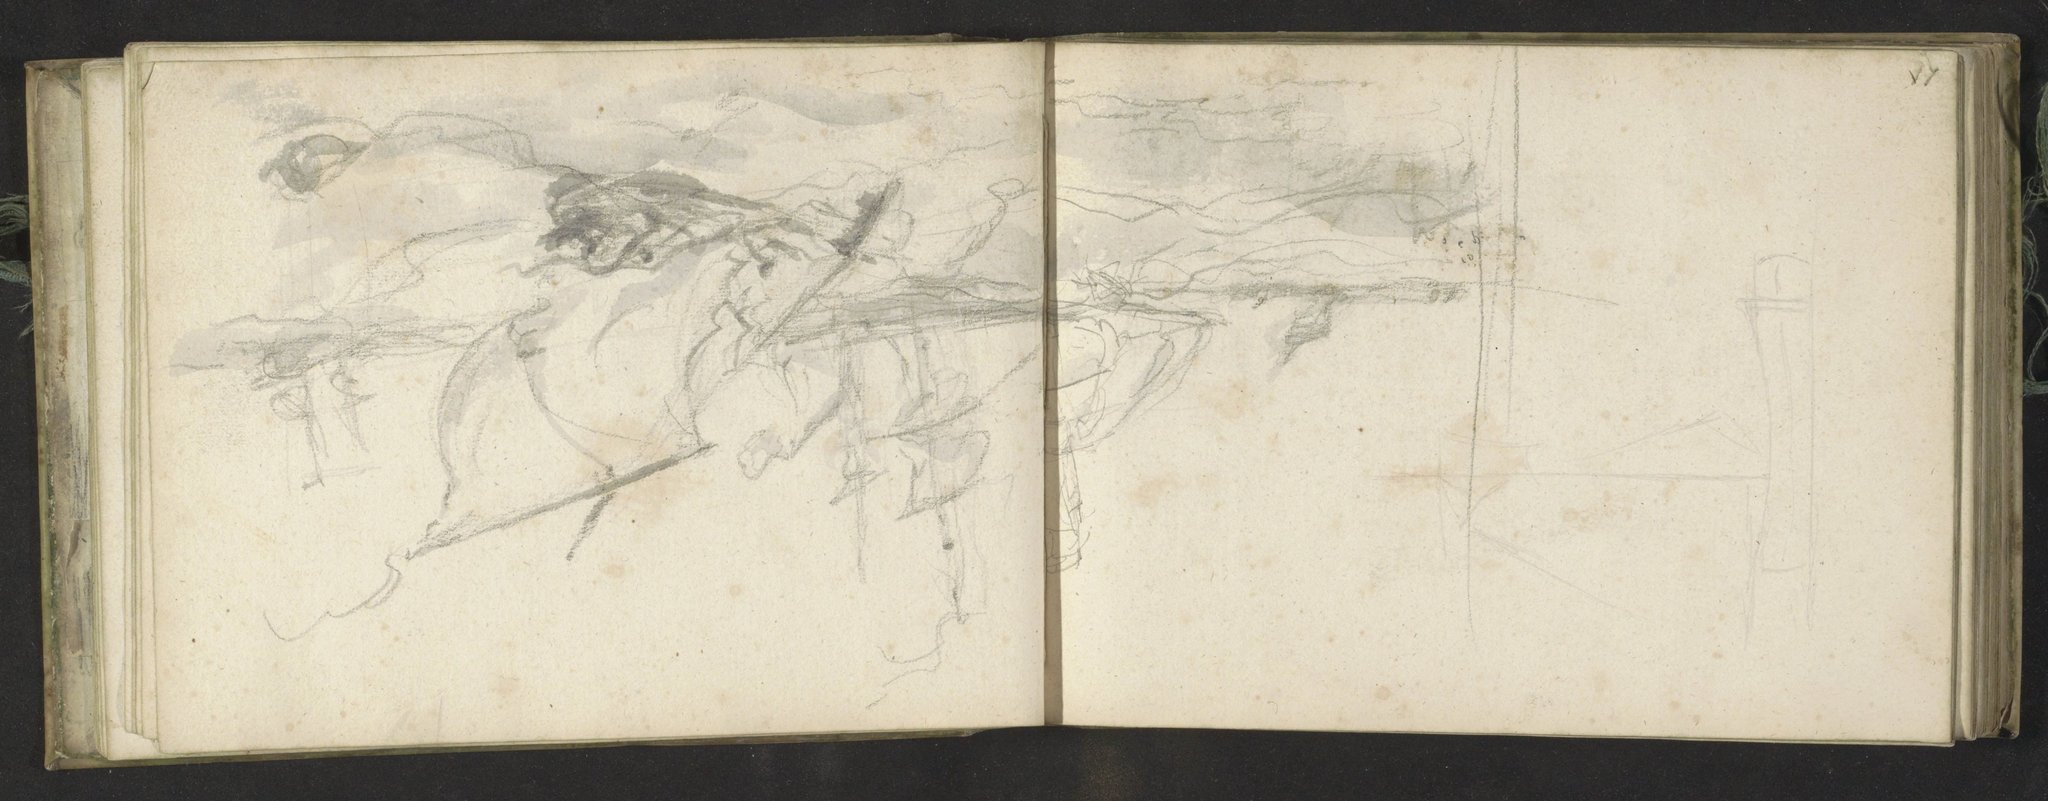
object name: sketchbook leaf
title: Zeilschepen op een woelige zee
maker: martinus schouman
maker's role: draughtsman, painter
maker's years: 1770-1848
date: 1780-1848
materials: paper, pencil, watercolor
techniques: brush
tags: sailing-ship, sailing-boat, landscapes with waters, waterscapes, seascapes (in the temperate zone)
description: Tevens een studie van zeilboot. Blad 16 verso en 17 recto uit een schetsboek met 53 bladen.